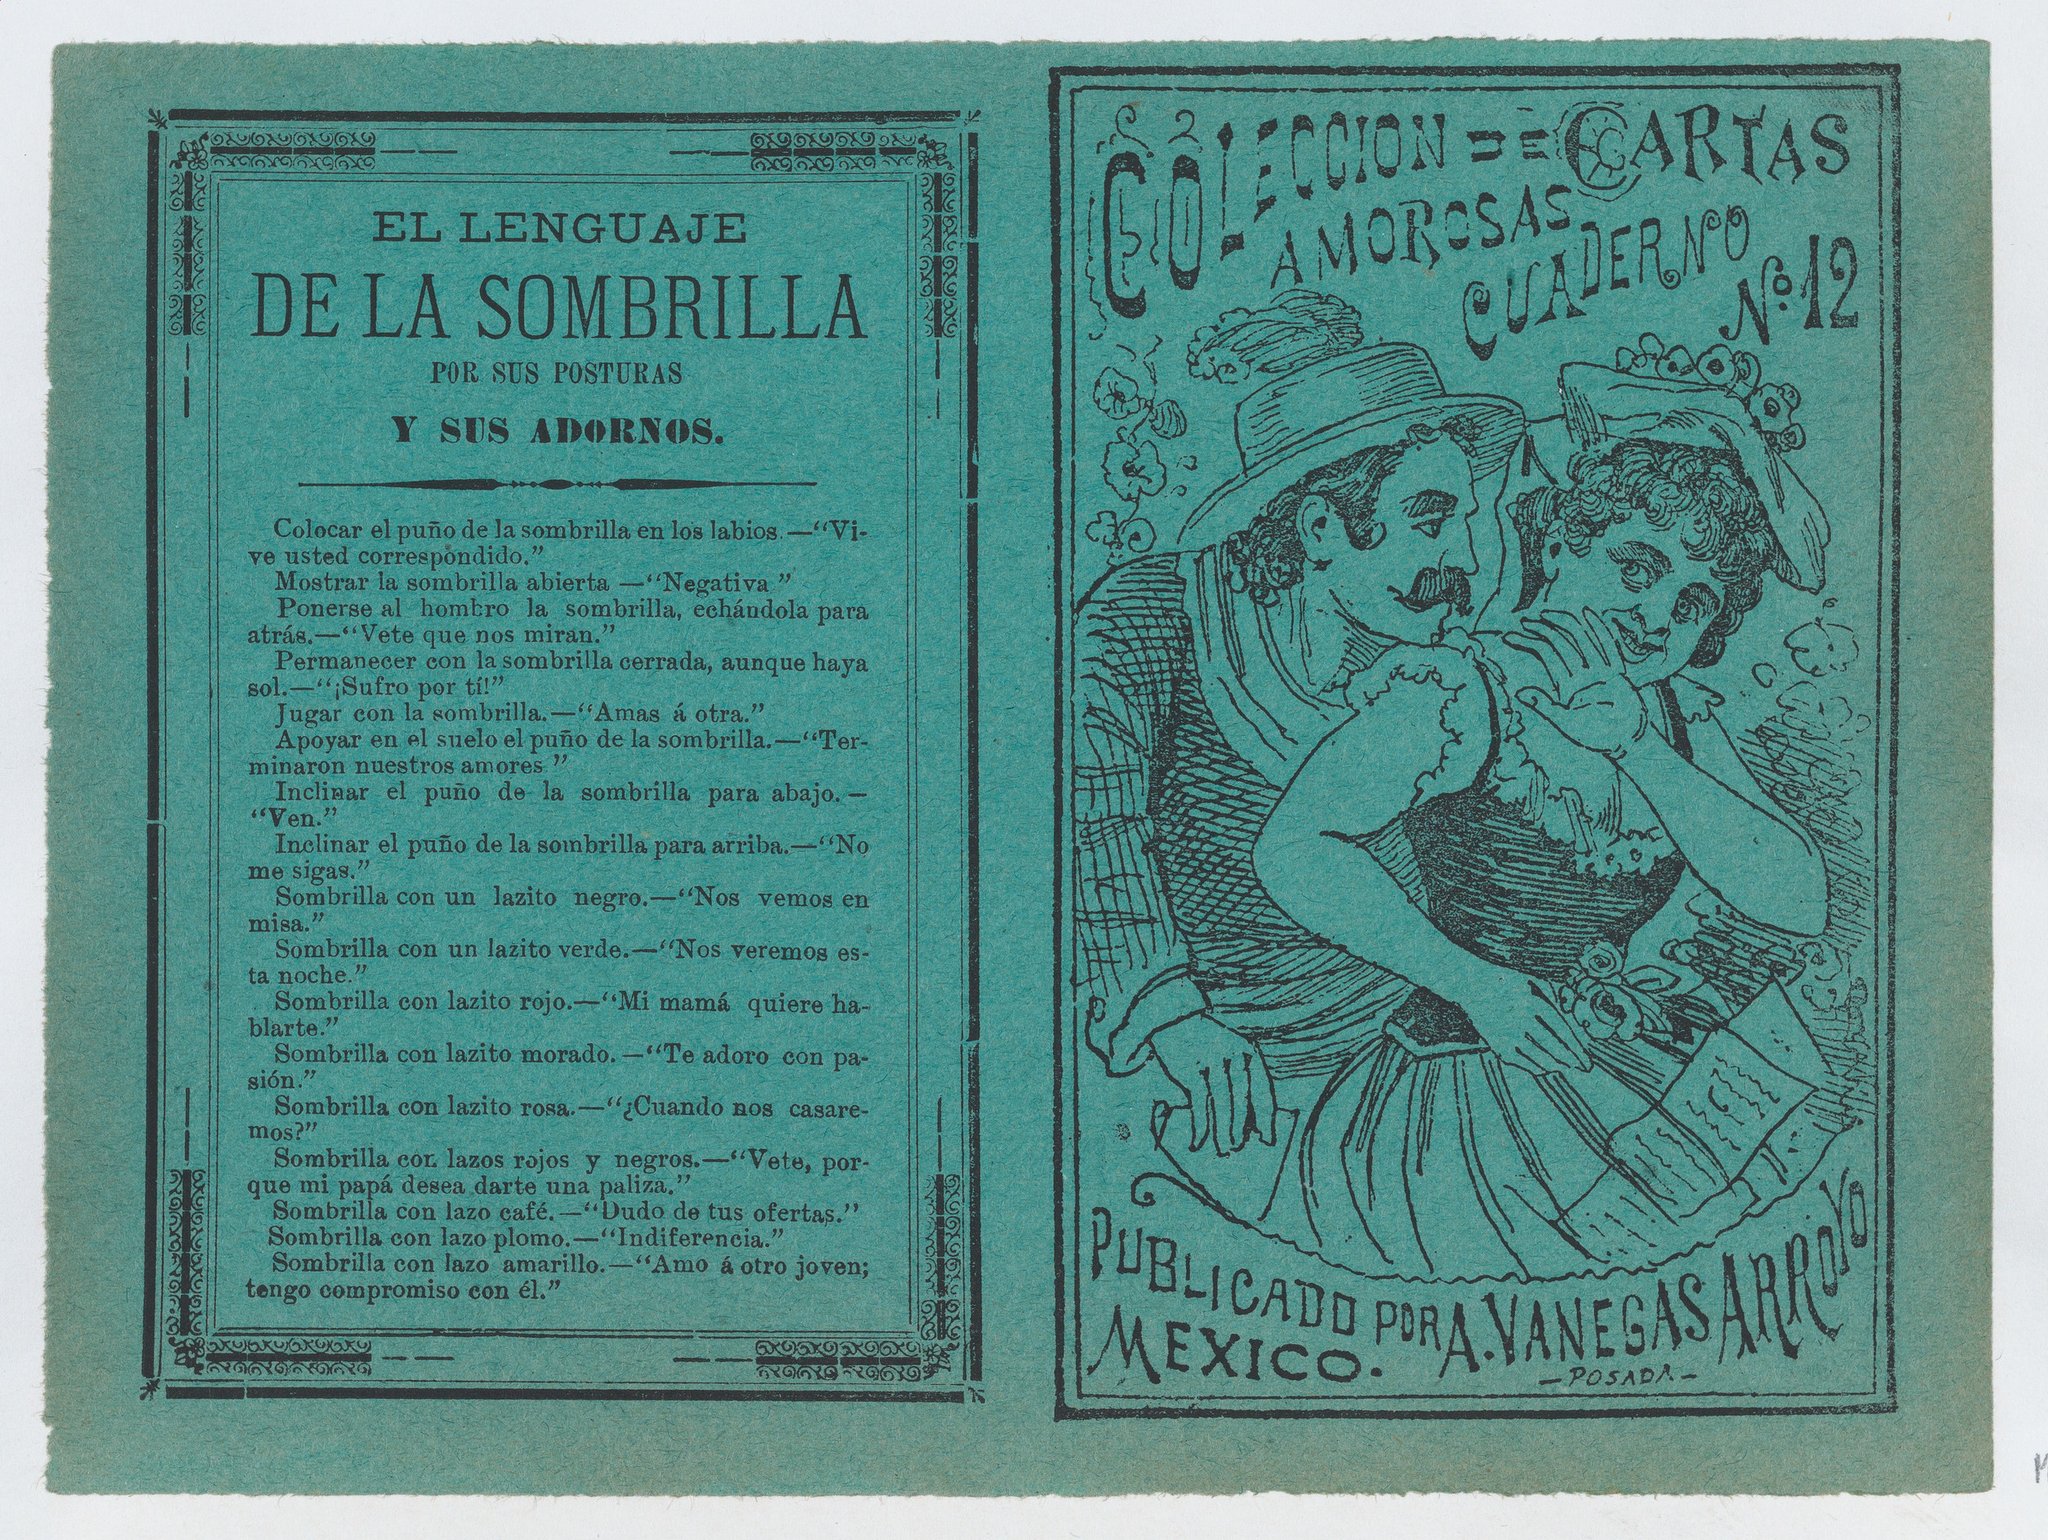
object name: print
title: Front and back covers printed on the same sheet for a collection of love letters / stories (number 12)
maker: josé guadalupe posada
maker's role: artist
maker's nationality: mexican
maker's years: 1852-1913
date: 1898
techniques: letterpress, lithography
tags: men,women